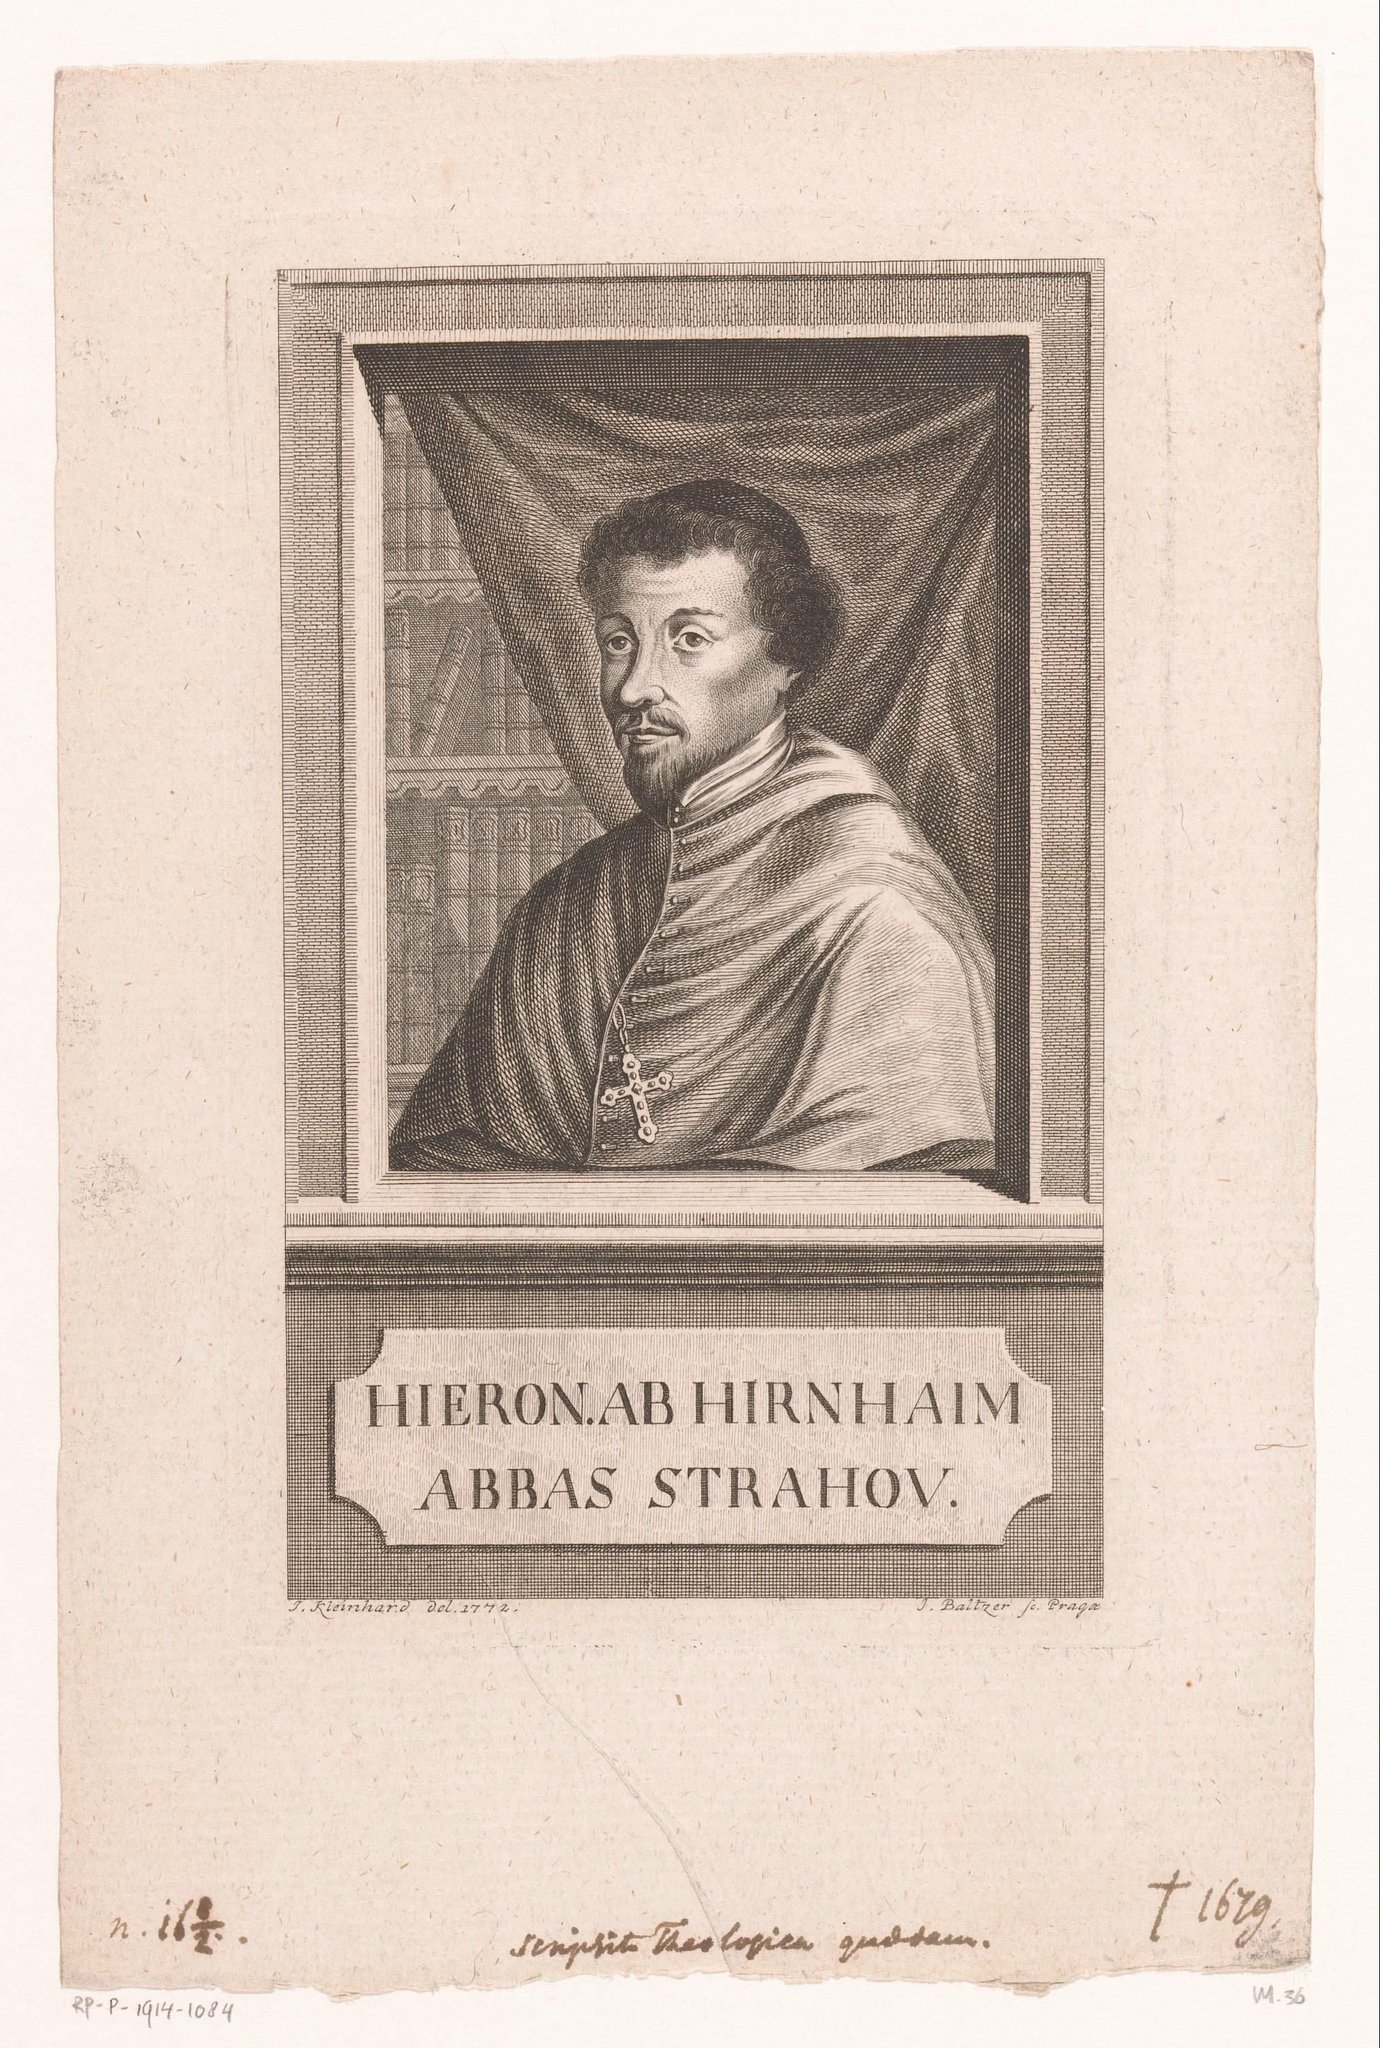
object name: print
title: Portret van Hieronymus Hirnheim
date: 1772-1799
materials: paper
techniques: engraving, etching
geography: prague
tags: bookshelves, historical persons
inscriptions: collector's mark: Lugt 2228